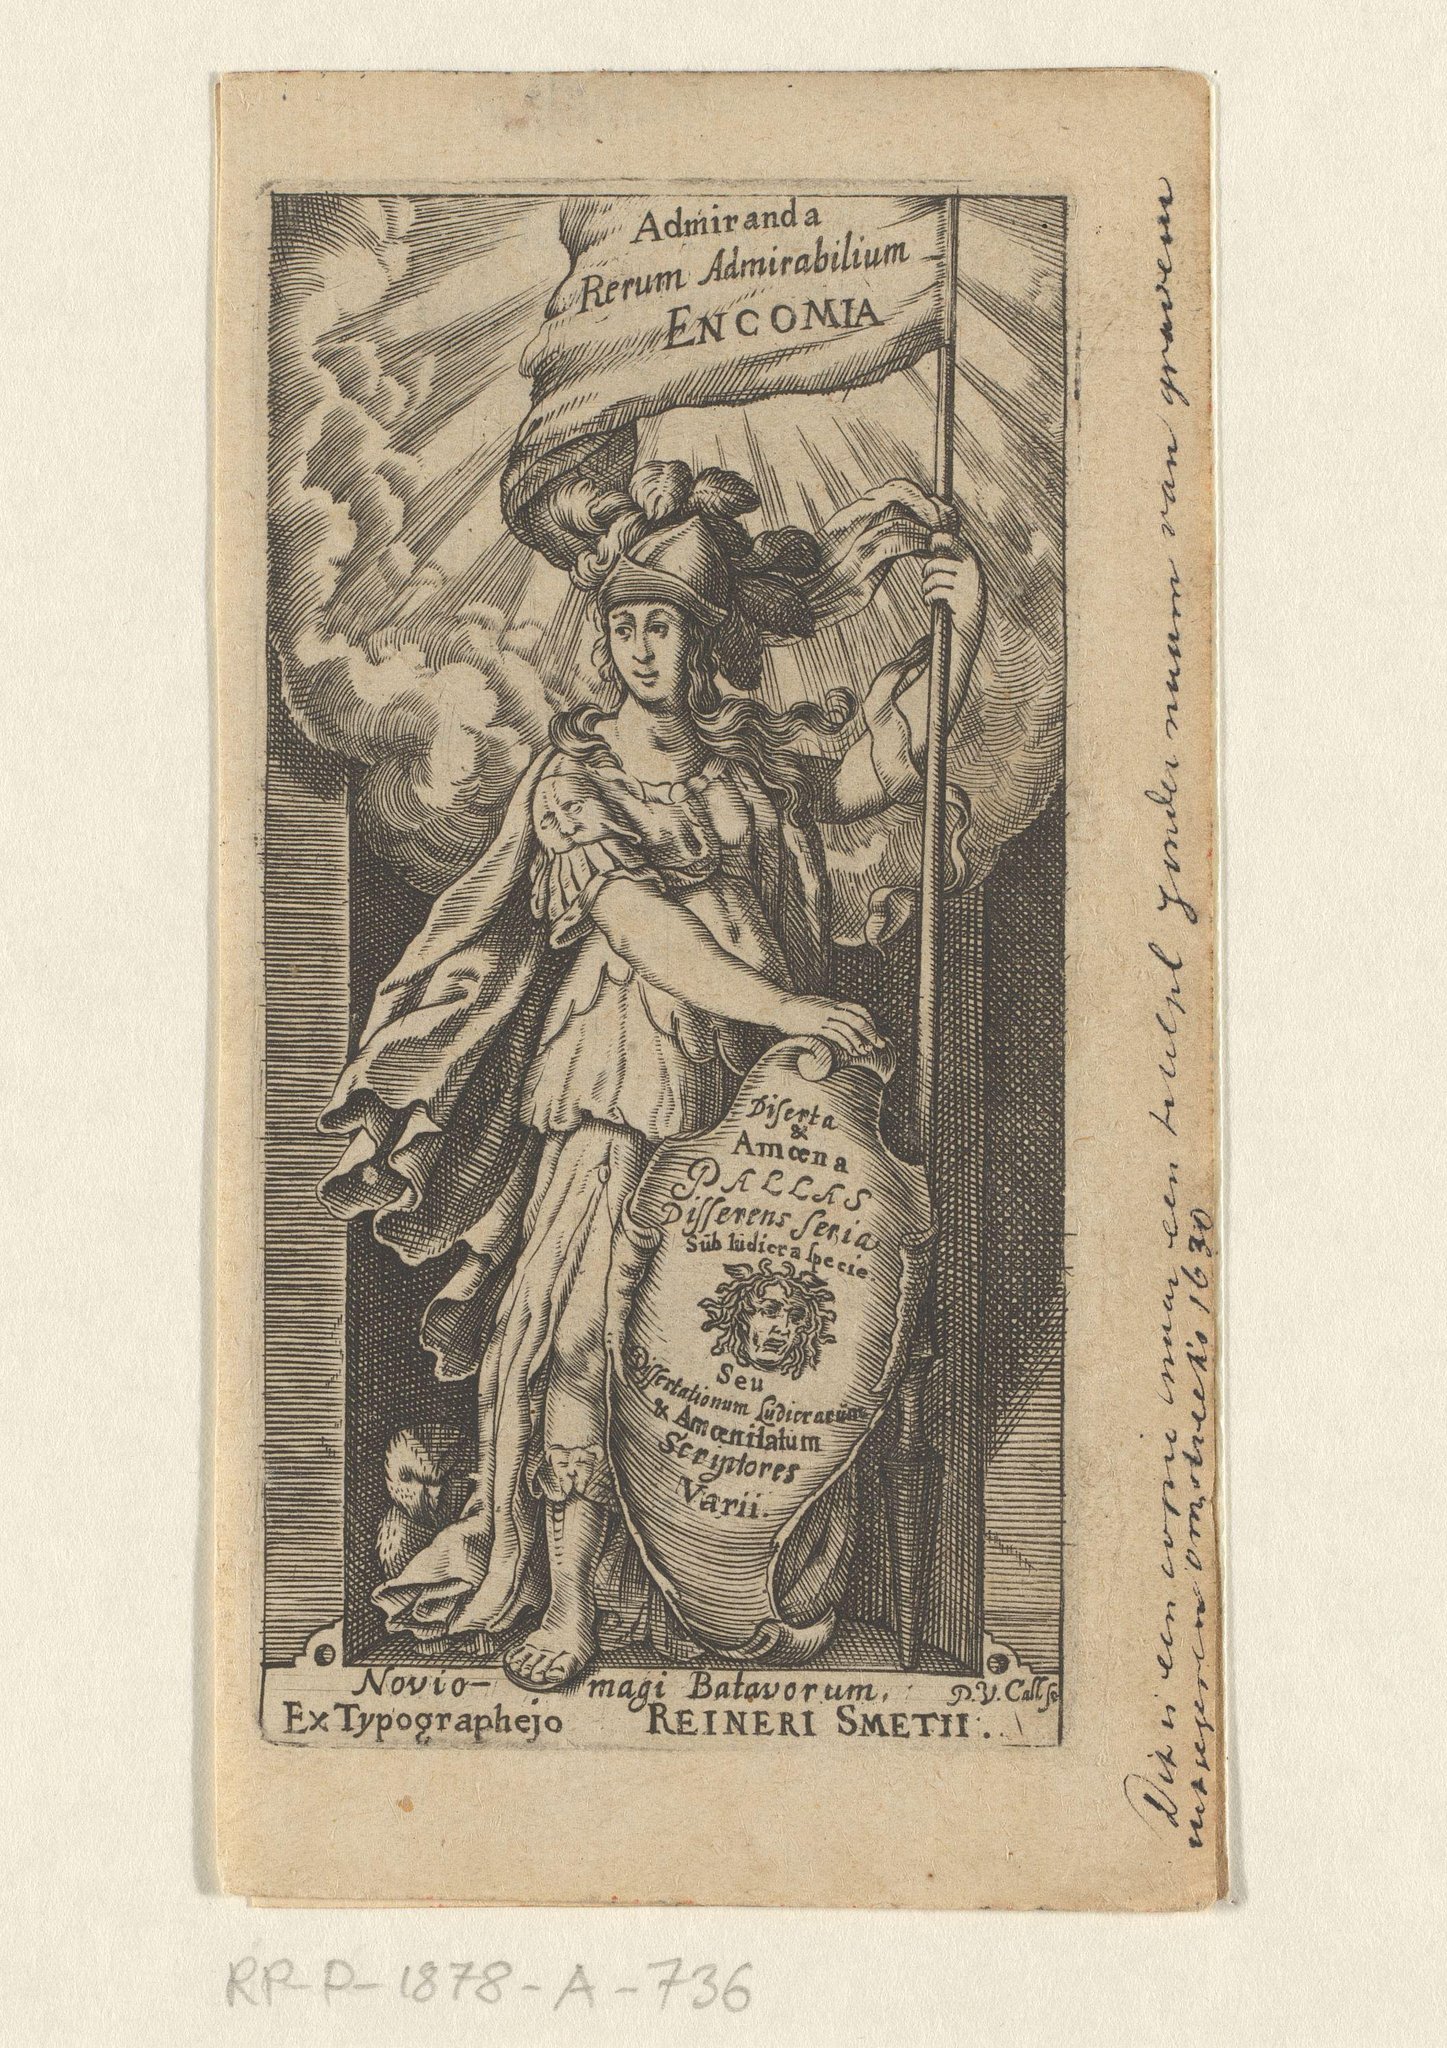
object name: titelblad, titelpagina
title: Titelpagina voor: Admiranda rerum admirabilium Encomia Noviomagi Batavorum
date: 1666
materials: paper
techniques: engraving, letterpress printing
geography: nijmegen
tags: (story of) minerva (pallas, athena)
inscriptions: collector's mark: Lugt 2228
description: Titelpagina voor: Admiranda rerum admirabilium encomia. Nijmegen: Regnerus Smetius, 1666. Prent geplakt op de typografische titelpagina.